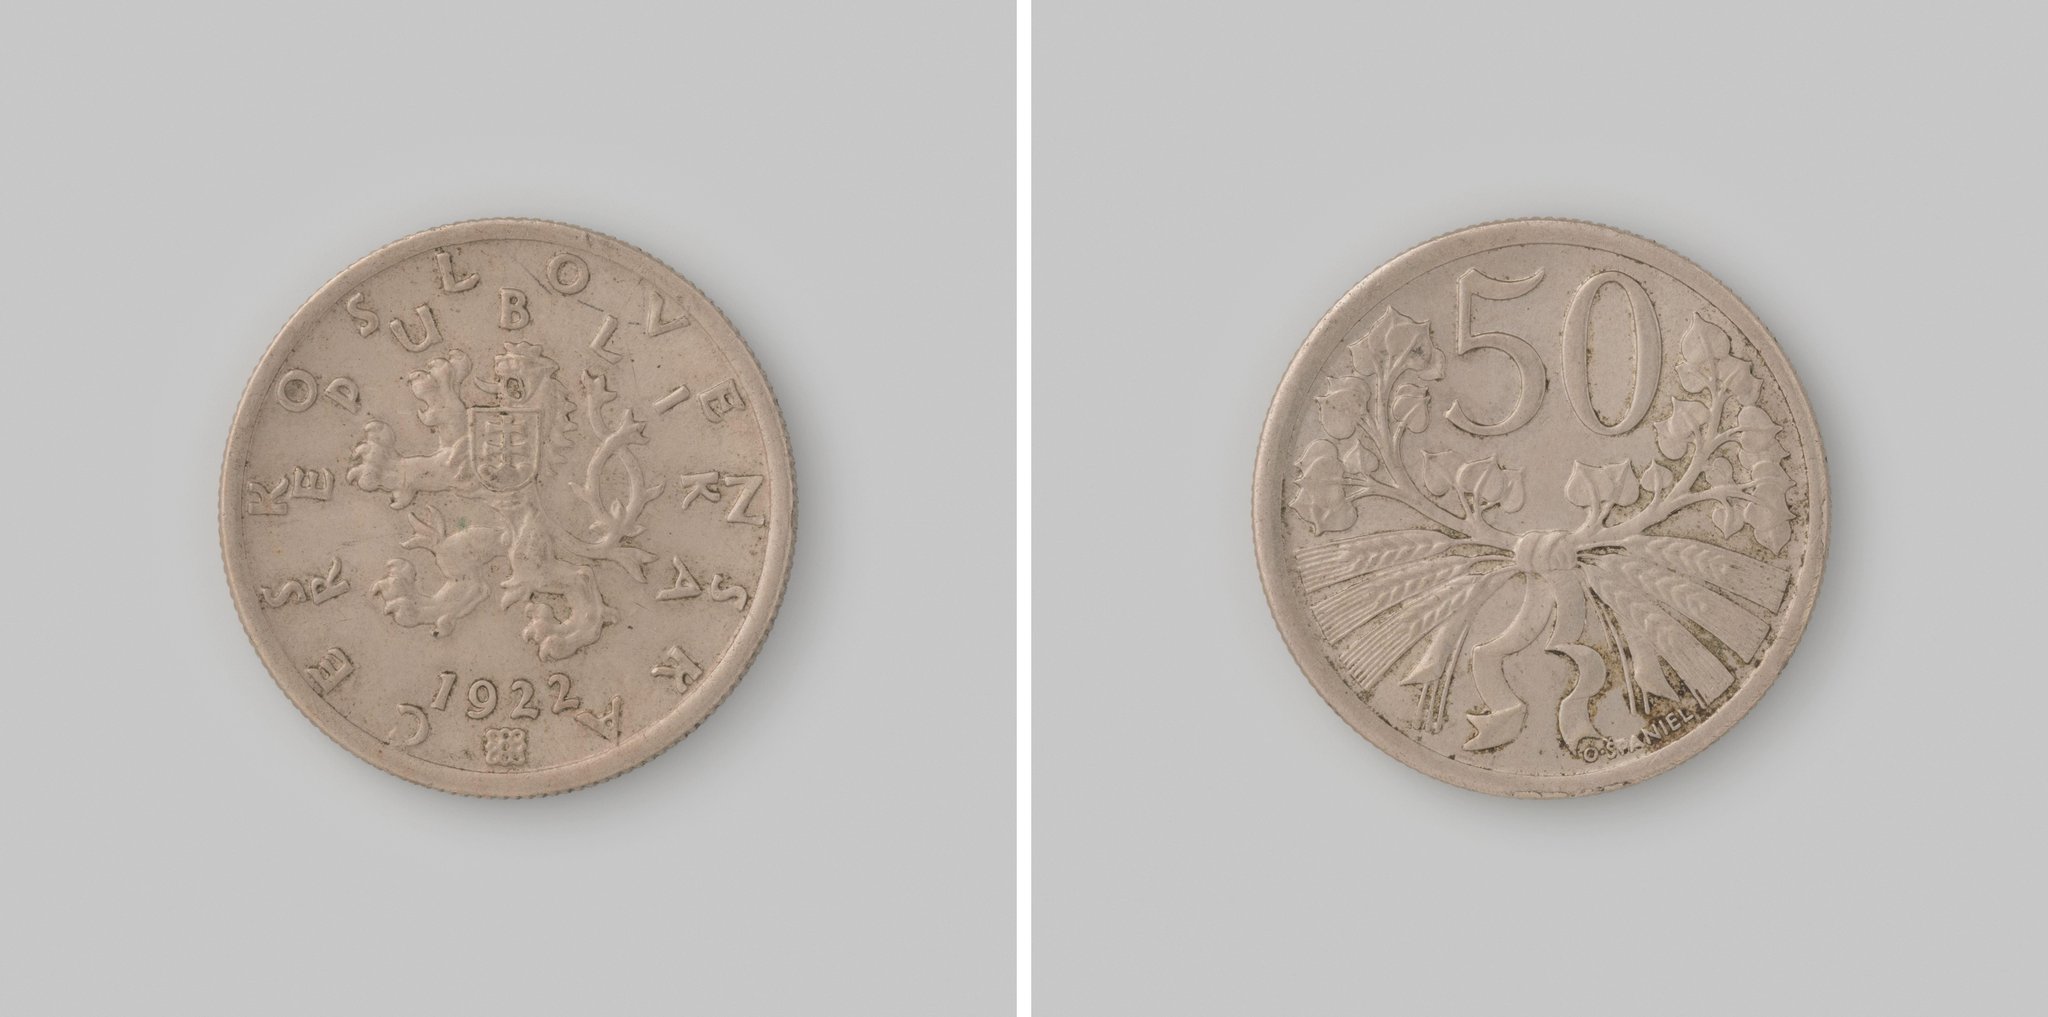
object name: coin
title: Tsjechoslowakije, 50 haleru, 1922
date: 1922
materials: nickel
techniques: striking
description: Koper-nikkelen munt. Voorzijde: klimmende leeuw met dubbele staart naar links met op zijn borst een wapenschild. Jaartal onder de leeuw. Keerzijde: tussen twee samengebonden takken en korenaren waarde-aanduiding: 50. Kartelrand.